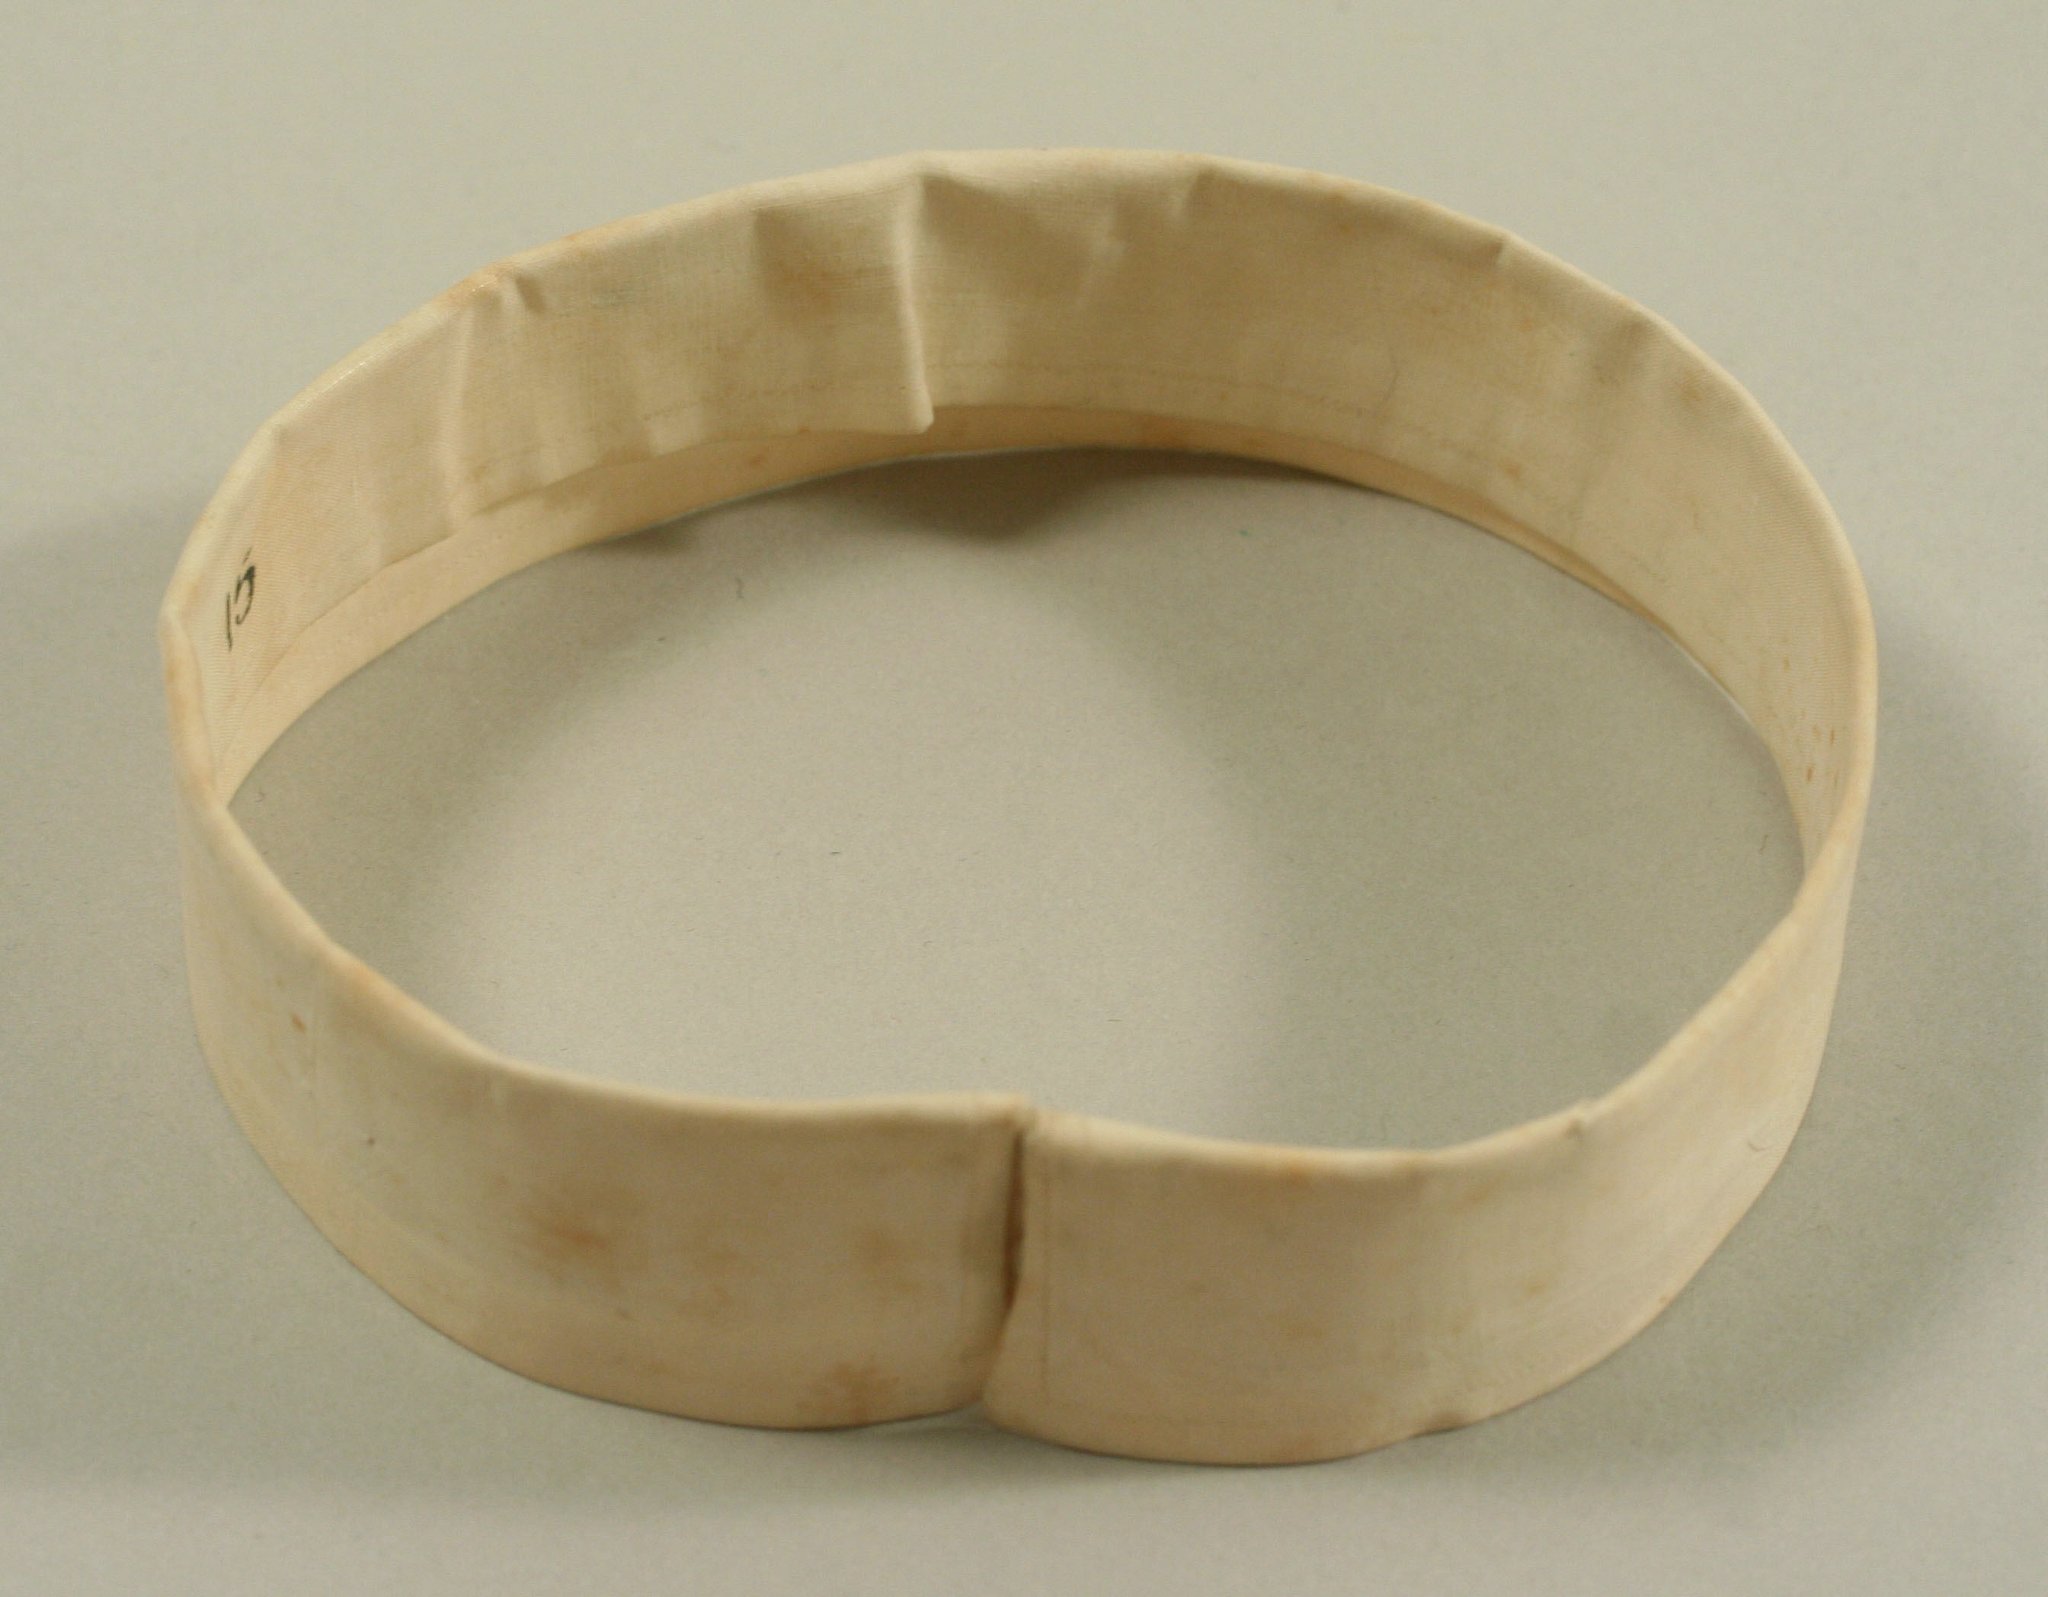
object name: collar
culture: american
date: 1880-1884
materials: linen